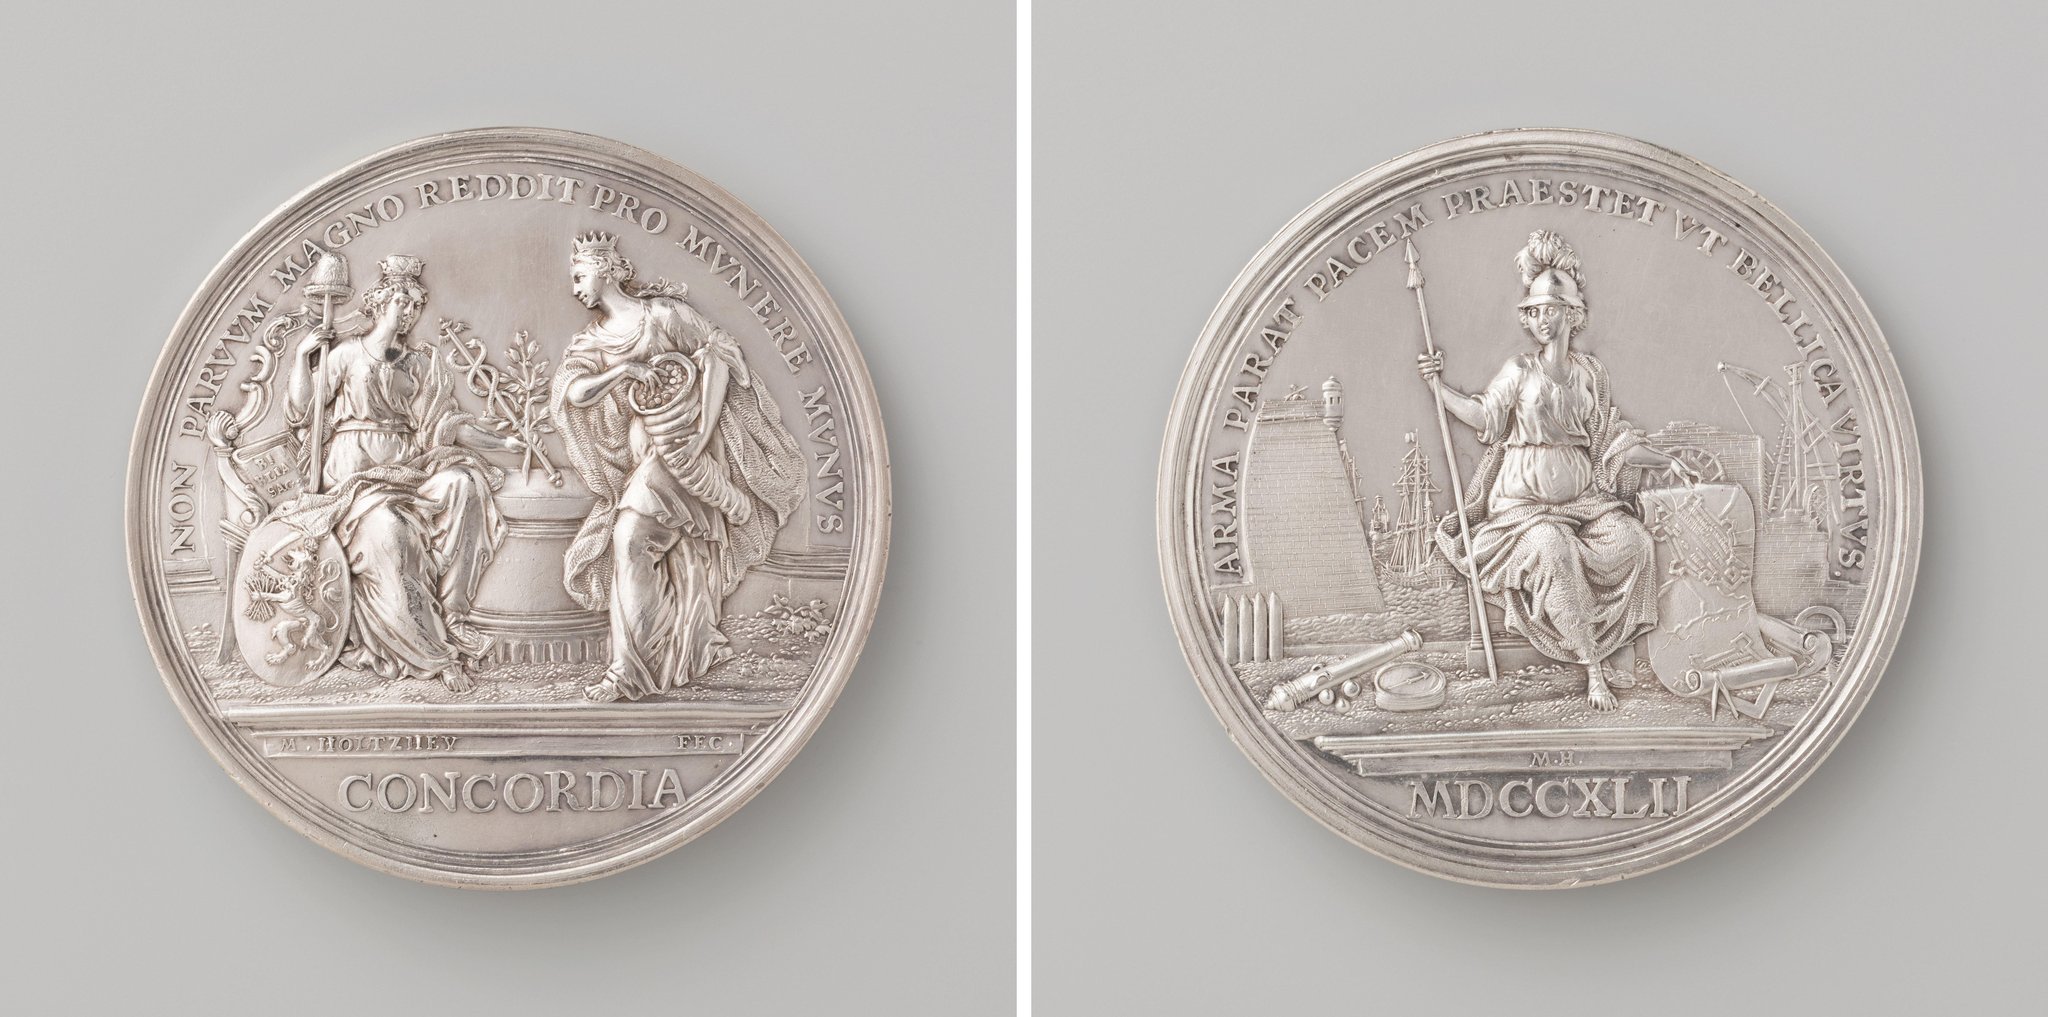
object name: history medal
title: Voorbereidingen voor oorlog in de Nederlanden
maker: martinus holtzhey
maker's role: medailleur, muntmaker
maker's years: 1697-1764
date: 1742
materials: silver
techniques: striking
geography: amsterdam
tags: low countries